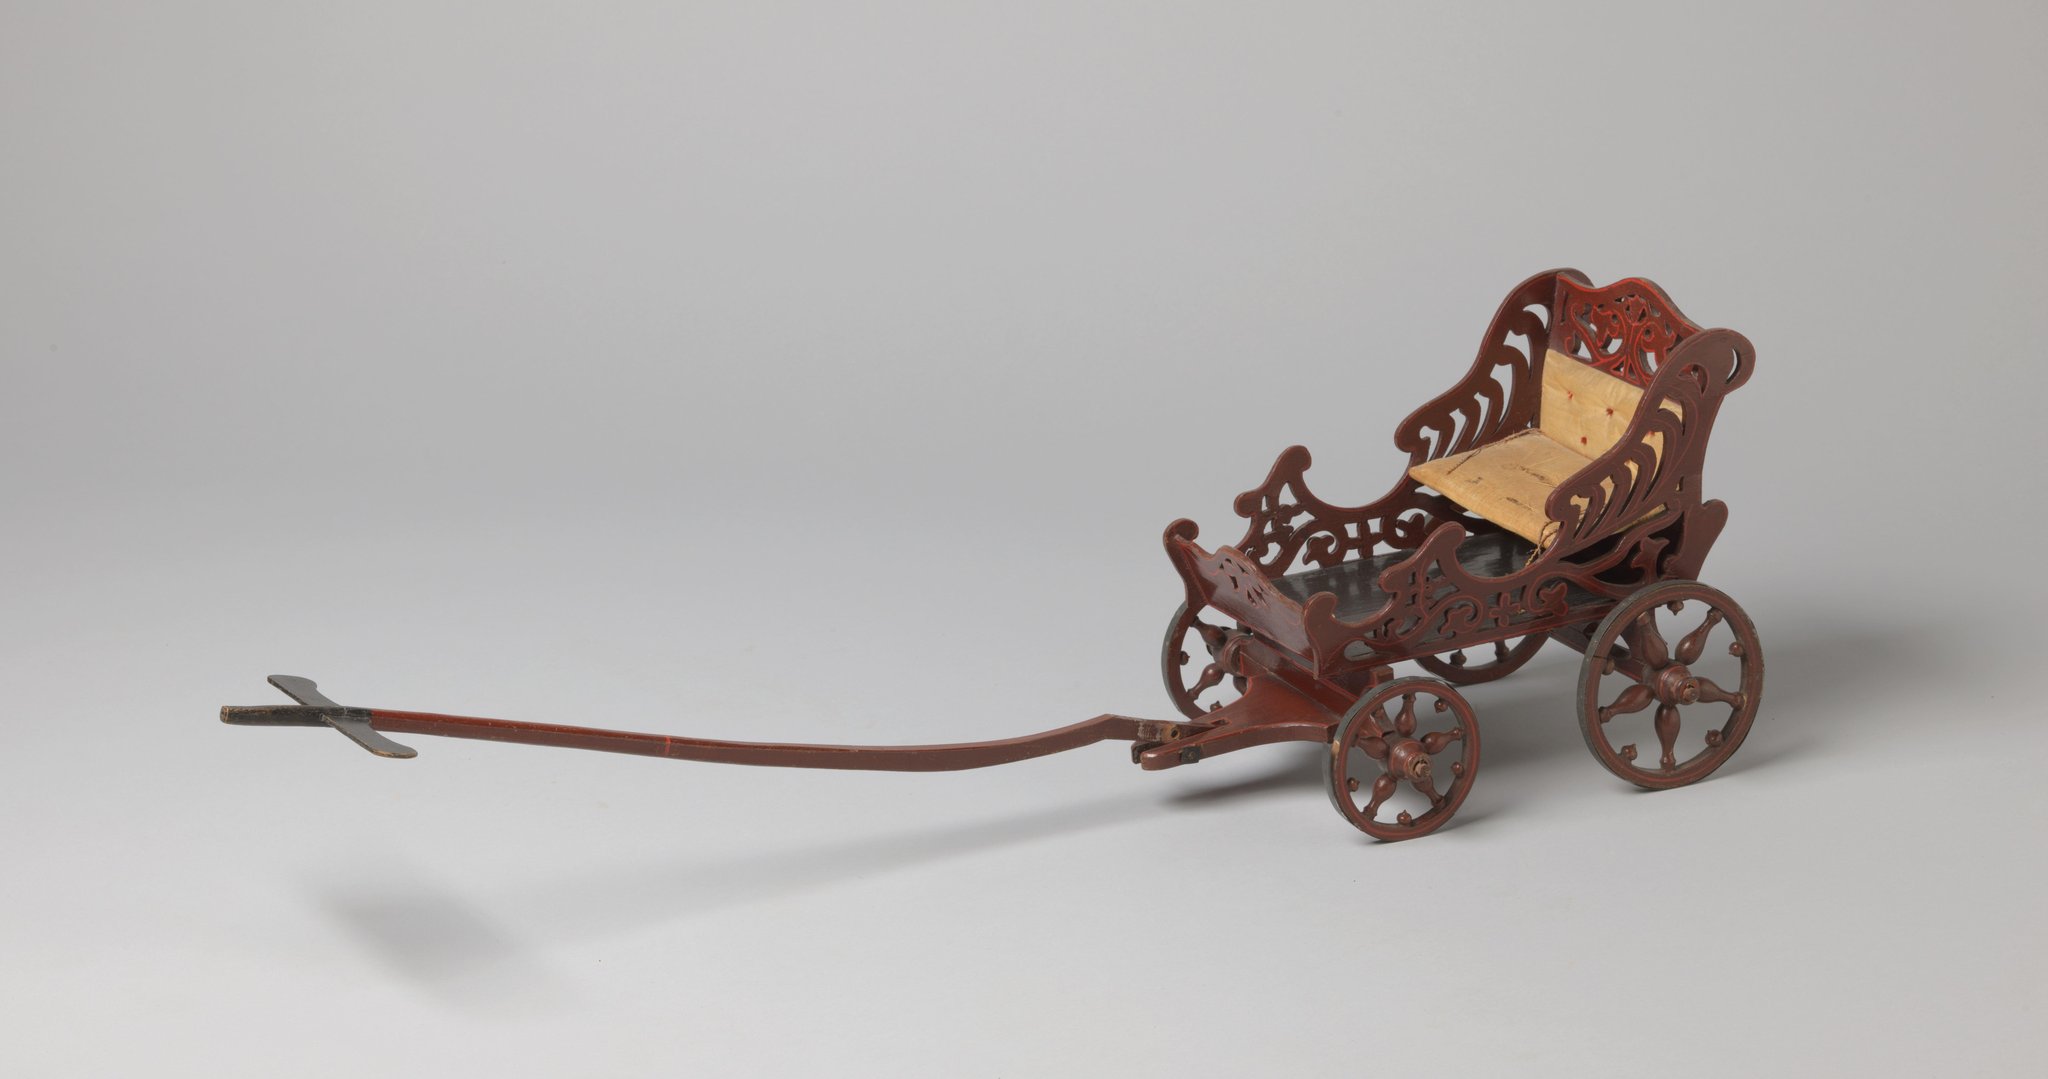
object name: toy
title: Model van een wagen op vier wielen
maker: Anonymous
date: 1700-1800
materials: fiber, pigment, wood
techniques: painted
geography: northern netherlands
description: Model van een wagen op vier wielen, met uitgesneden wanden. De wagen is lakkleurig geschilderd en met vermiljoen afgezet. Speelgoed.